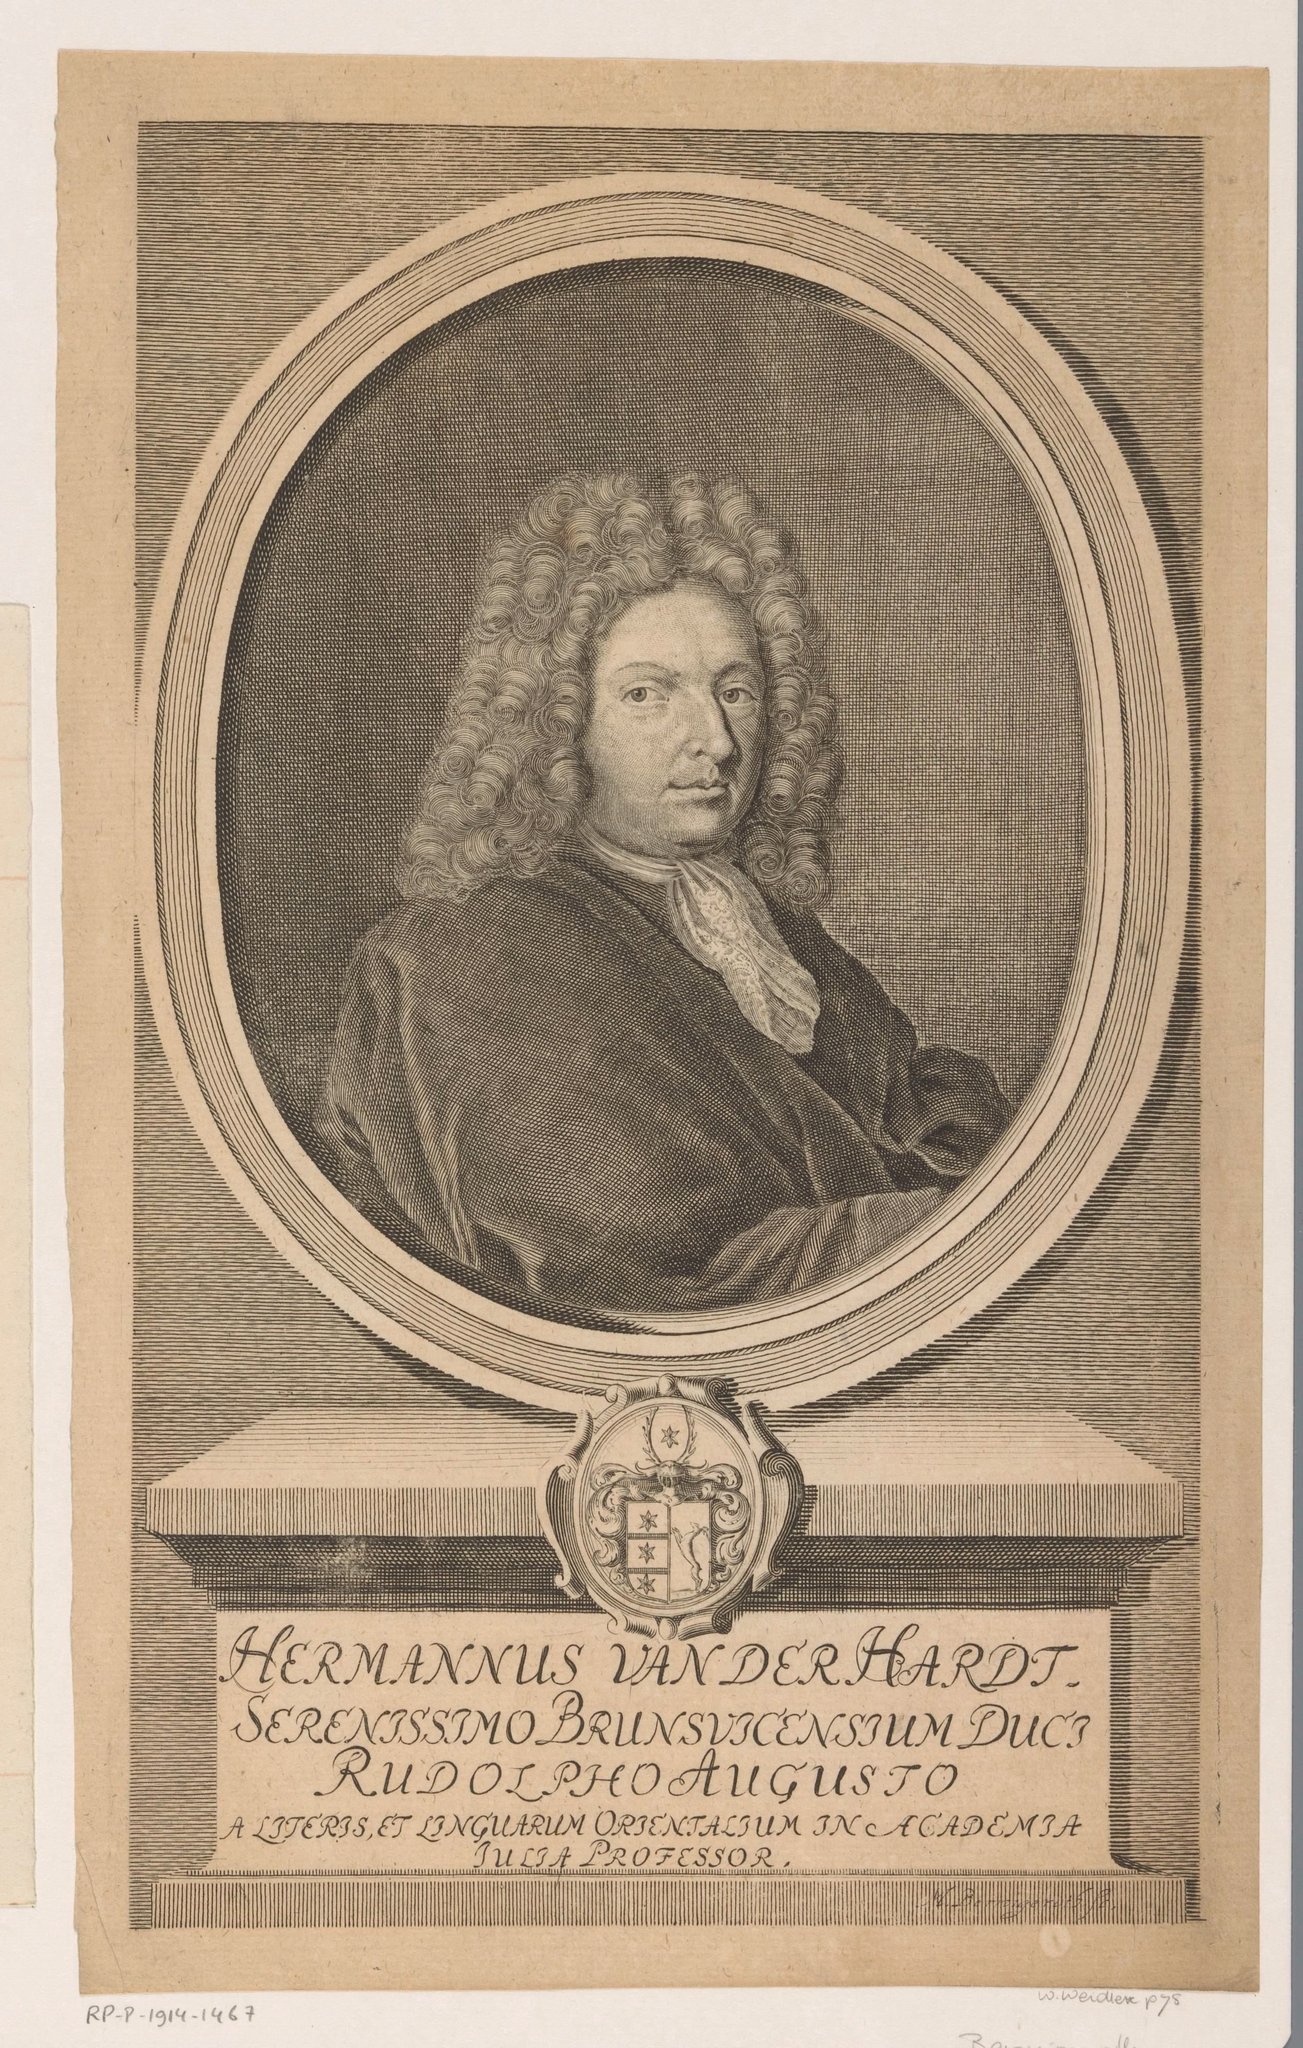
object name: print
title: Portret van Hermann von der Hardt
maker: martin bernigeroth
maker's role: print maker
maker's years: 1670-1733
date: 1680-1733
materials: paper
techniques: engraving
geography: leipzig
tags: historical persons, armorial bearing, heraldry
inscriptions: collector's mark: Lugt 2228